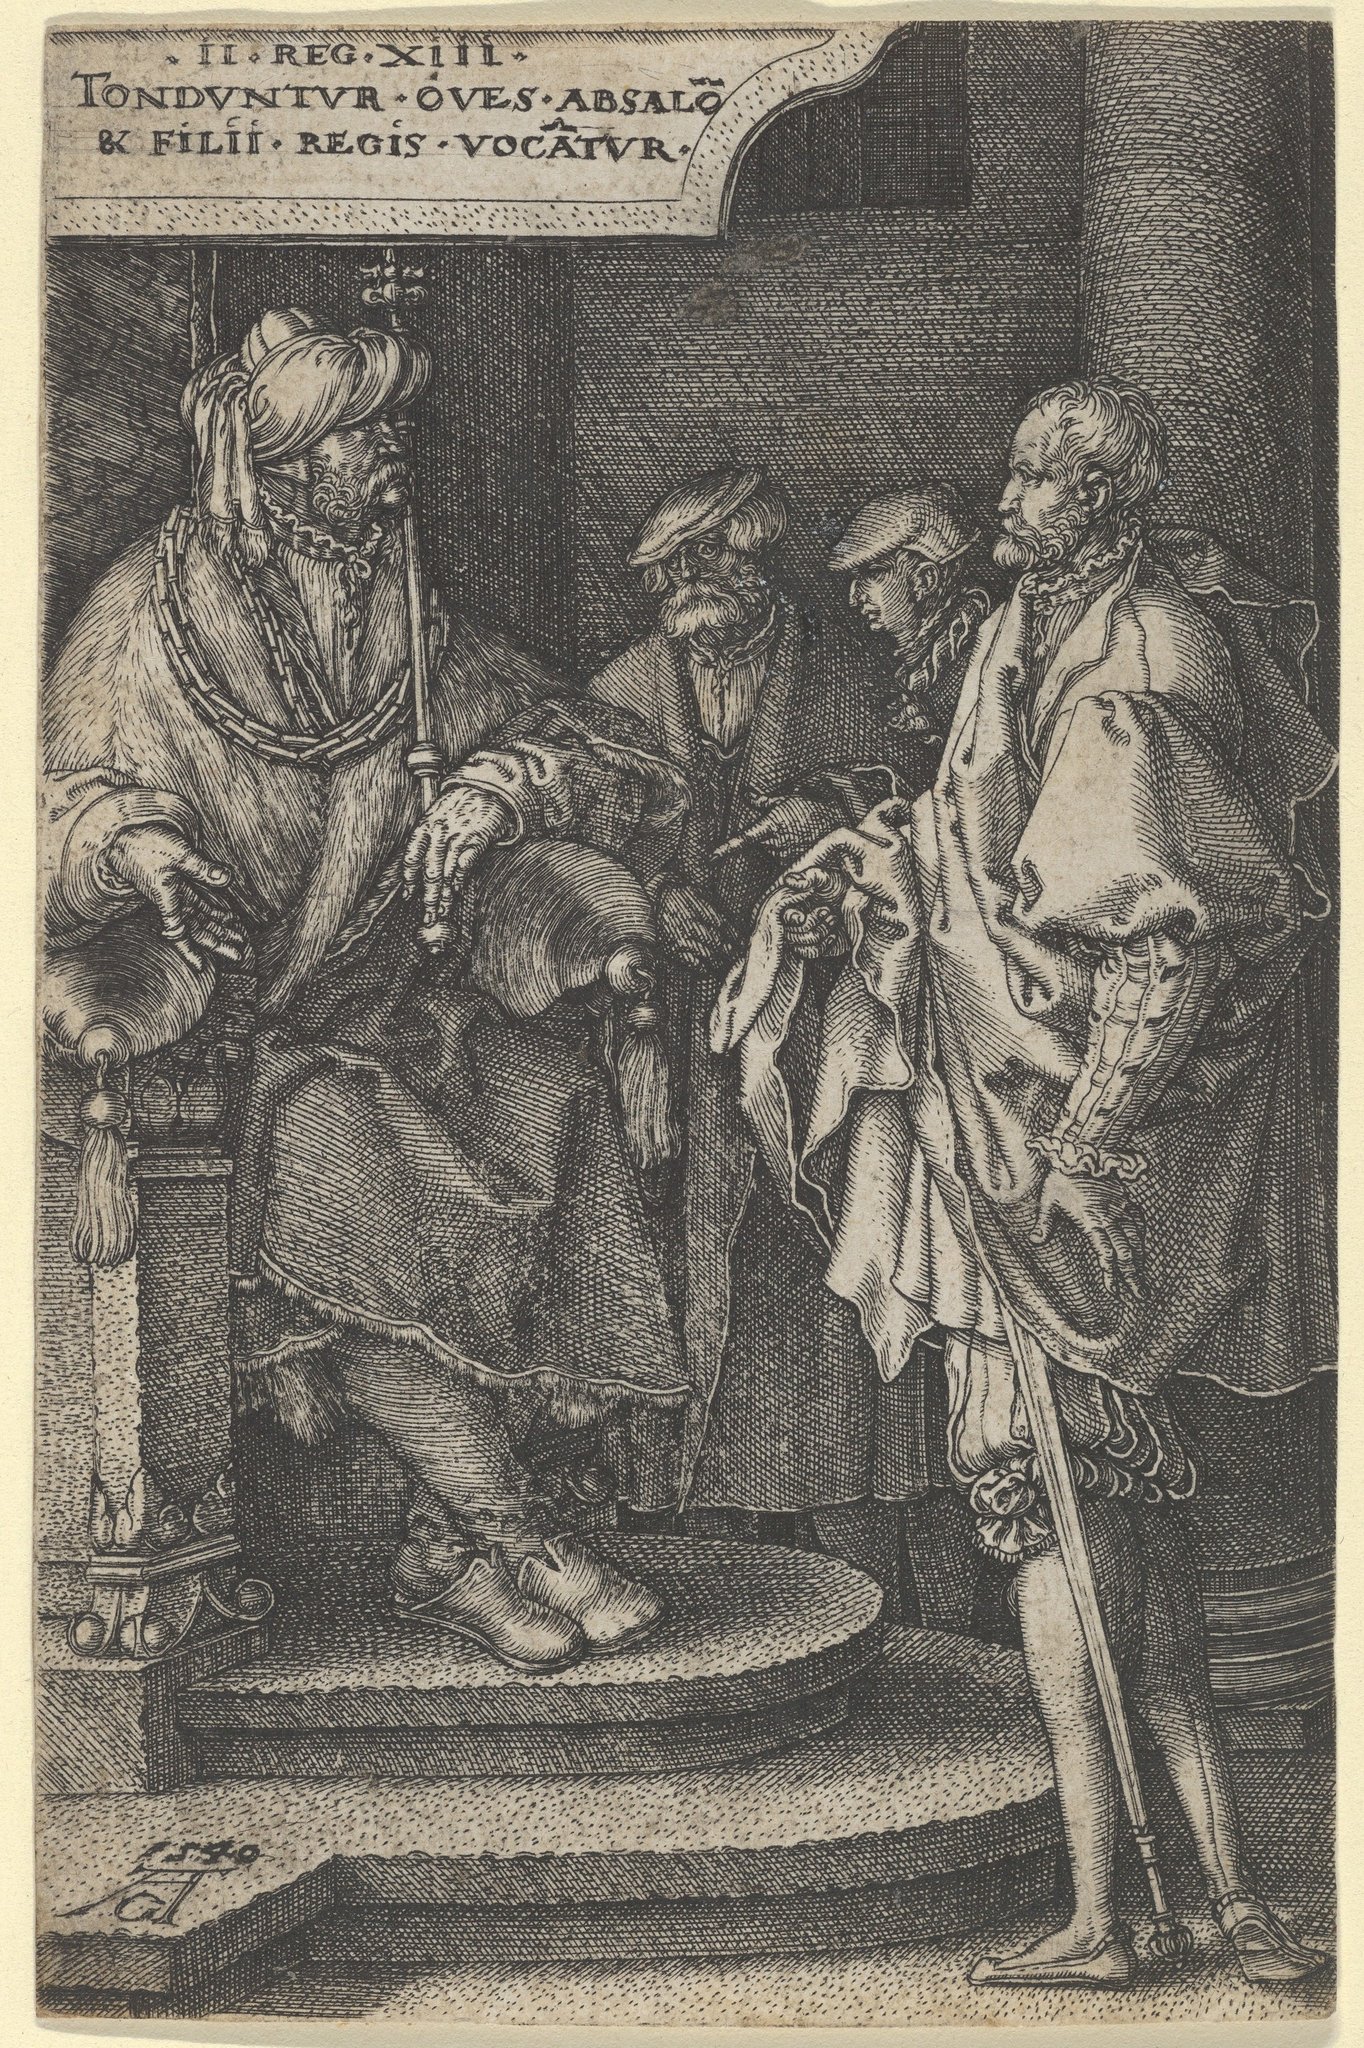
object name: print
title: Absalom Inviting David and His Brothers, from "The Story of Amnon and Tamar"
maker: heinrich aldegrever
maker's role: artist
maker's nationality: german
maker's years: 1502-1561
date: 1540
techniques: engraving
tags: men,david